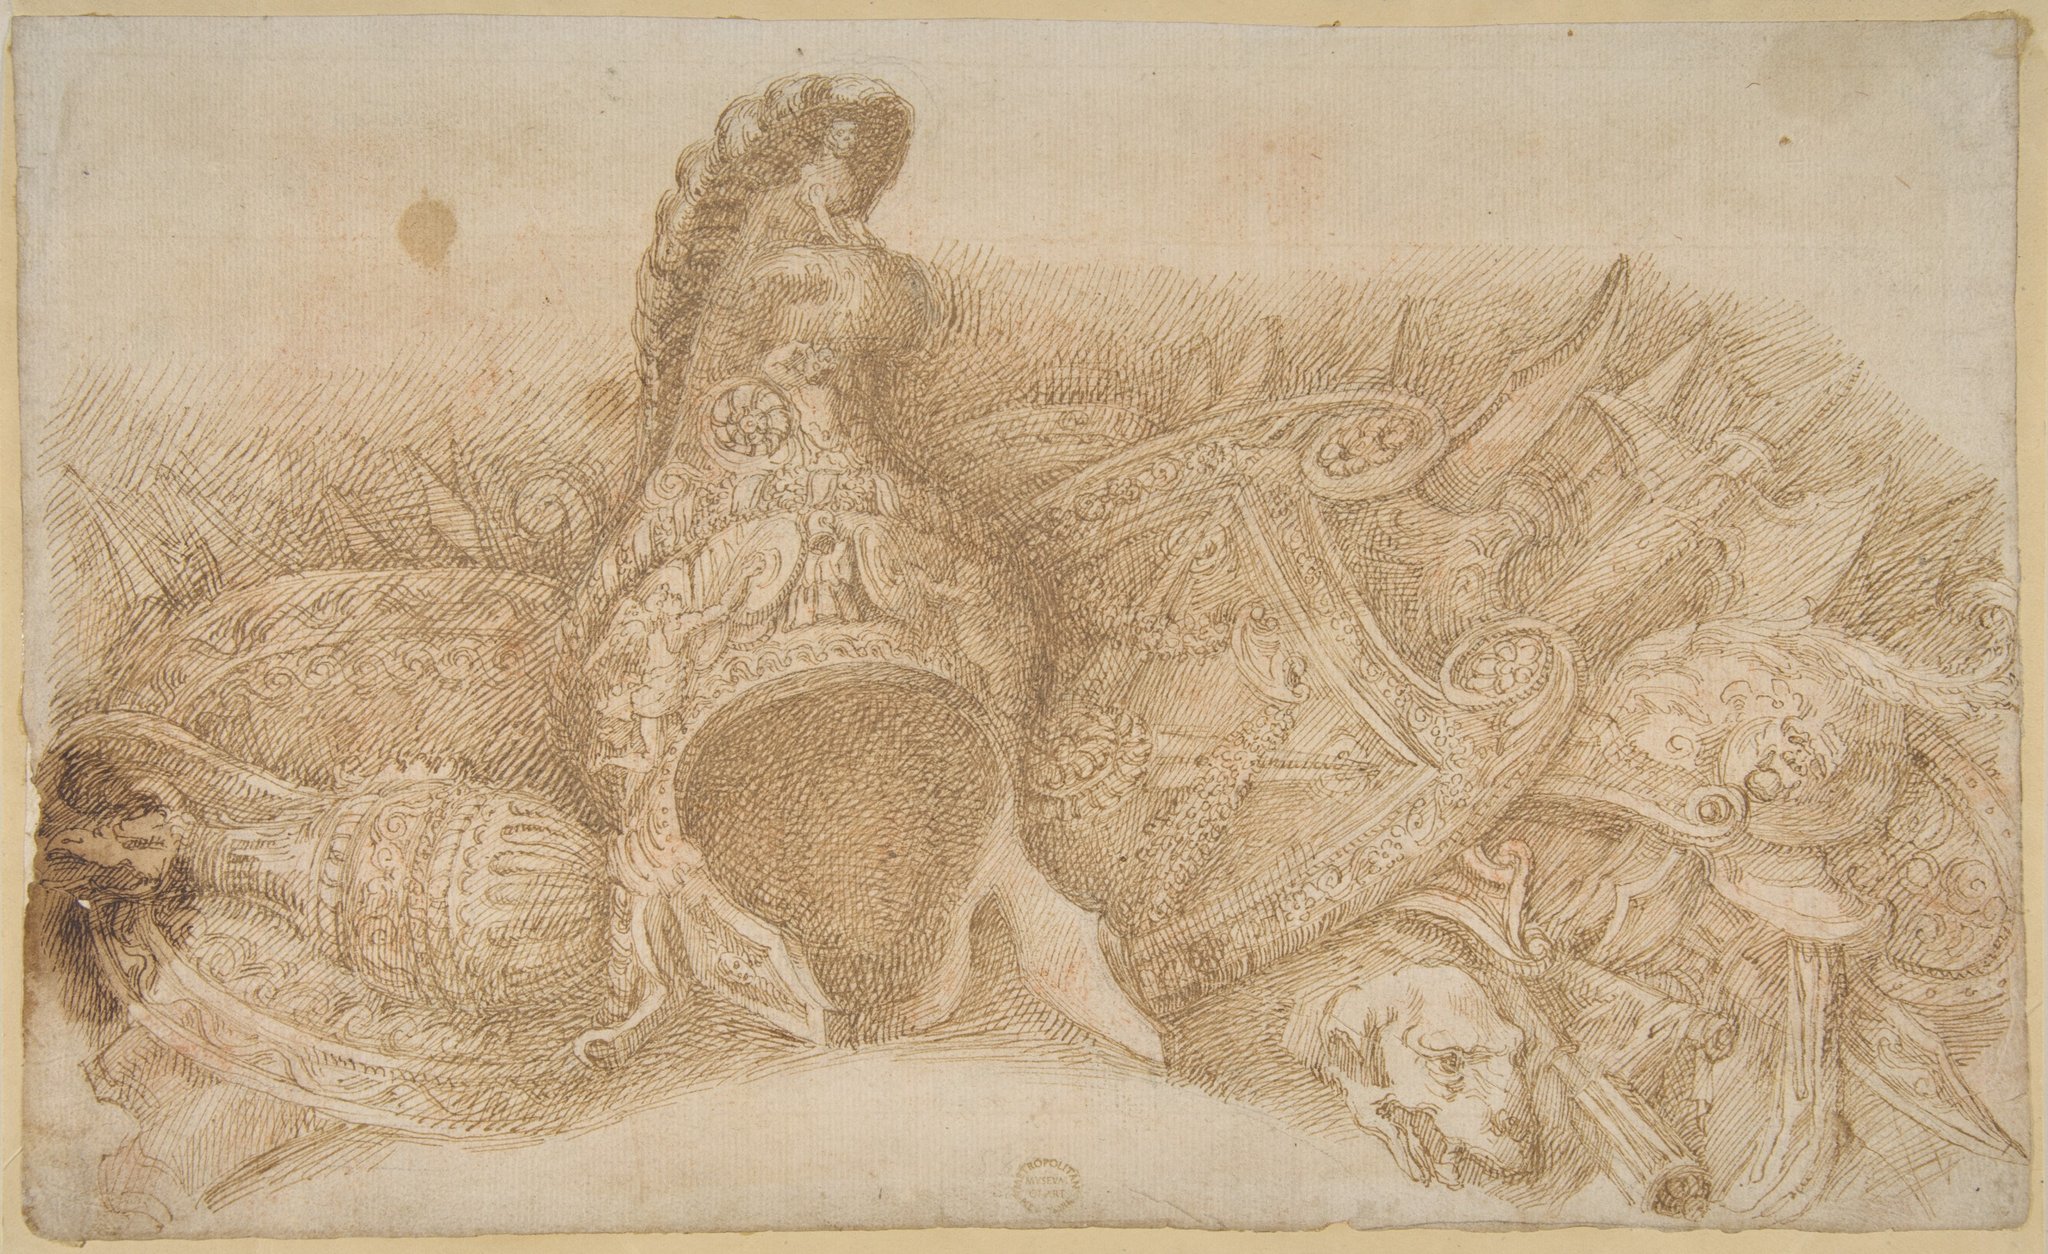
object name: drawing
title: Frieze of Trophies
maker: polidoro da caravaggio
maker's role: artist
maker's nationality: italian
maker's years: 1494-1548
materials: ink, drawing material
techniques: brush, pen, wash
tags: animals,trophies